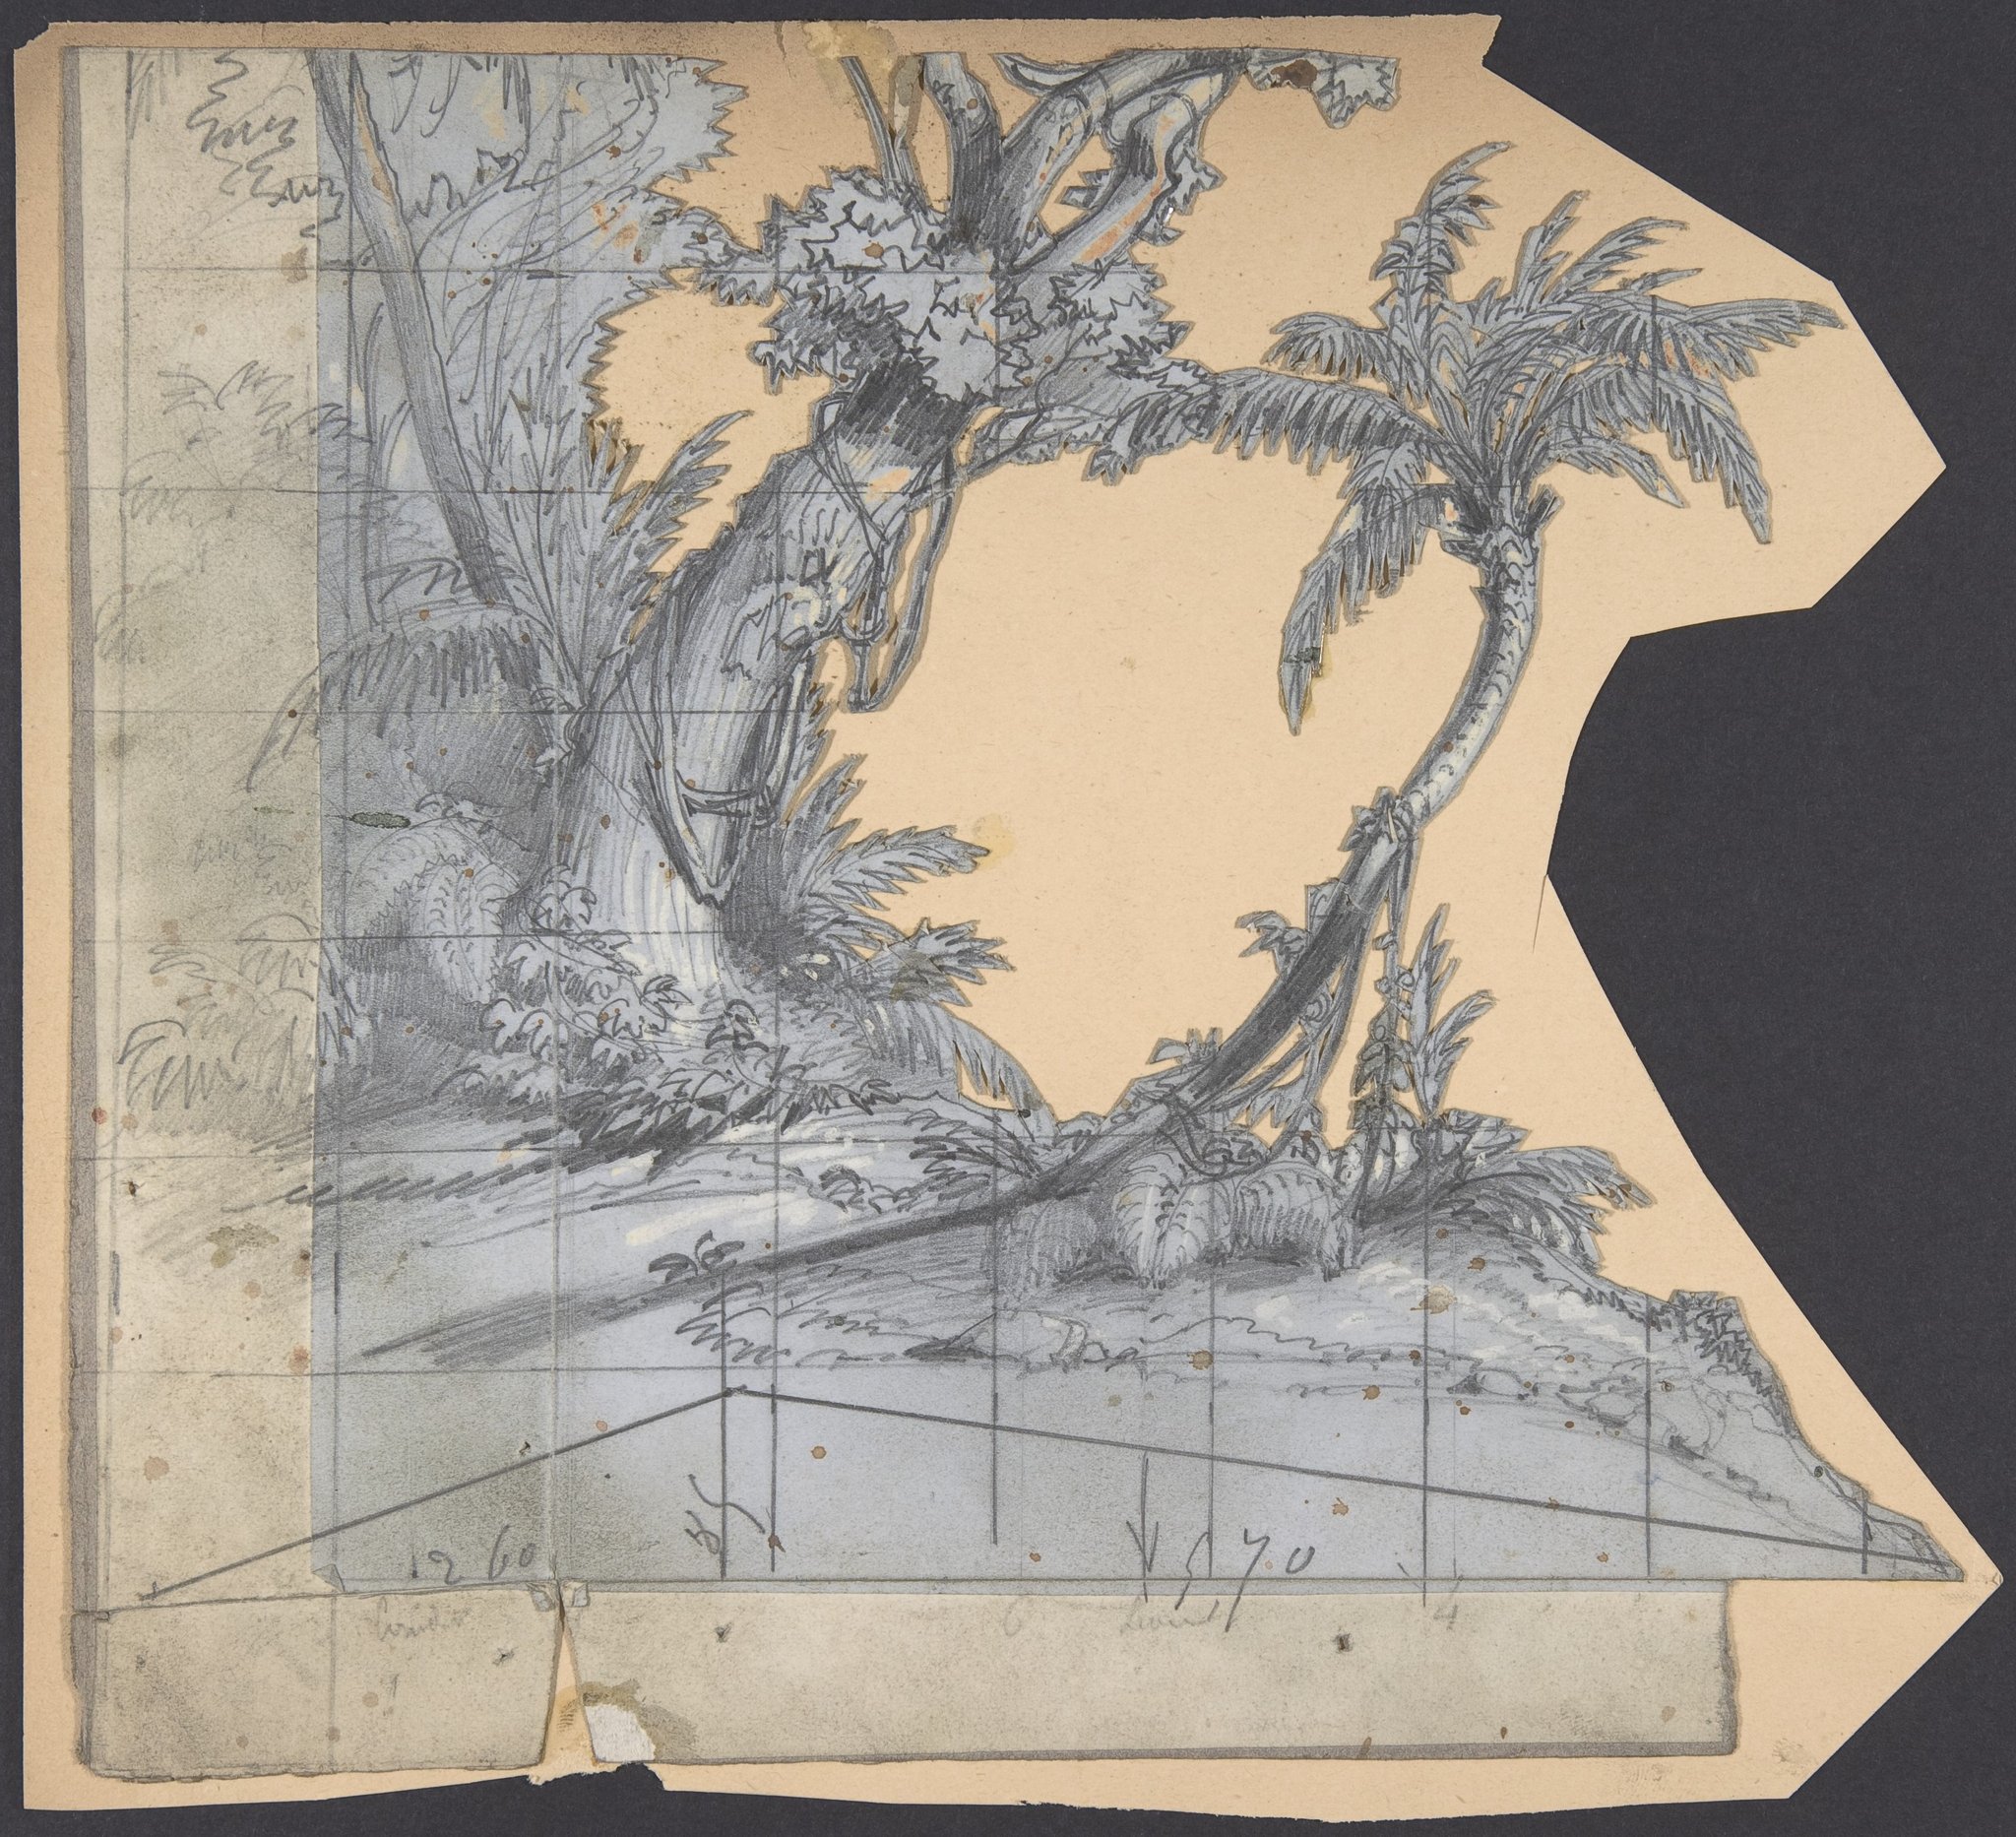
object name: drawing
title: Design for a Stage Set at the Opéra, Paris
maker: eugène cicéri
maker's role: artist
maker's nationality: french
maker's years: 1813-1890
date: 1830-1890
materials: graphite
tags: trees,stage design